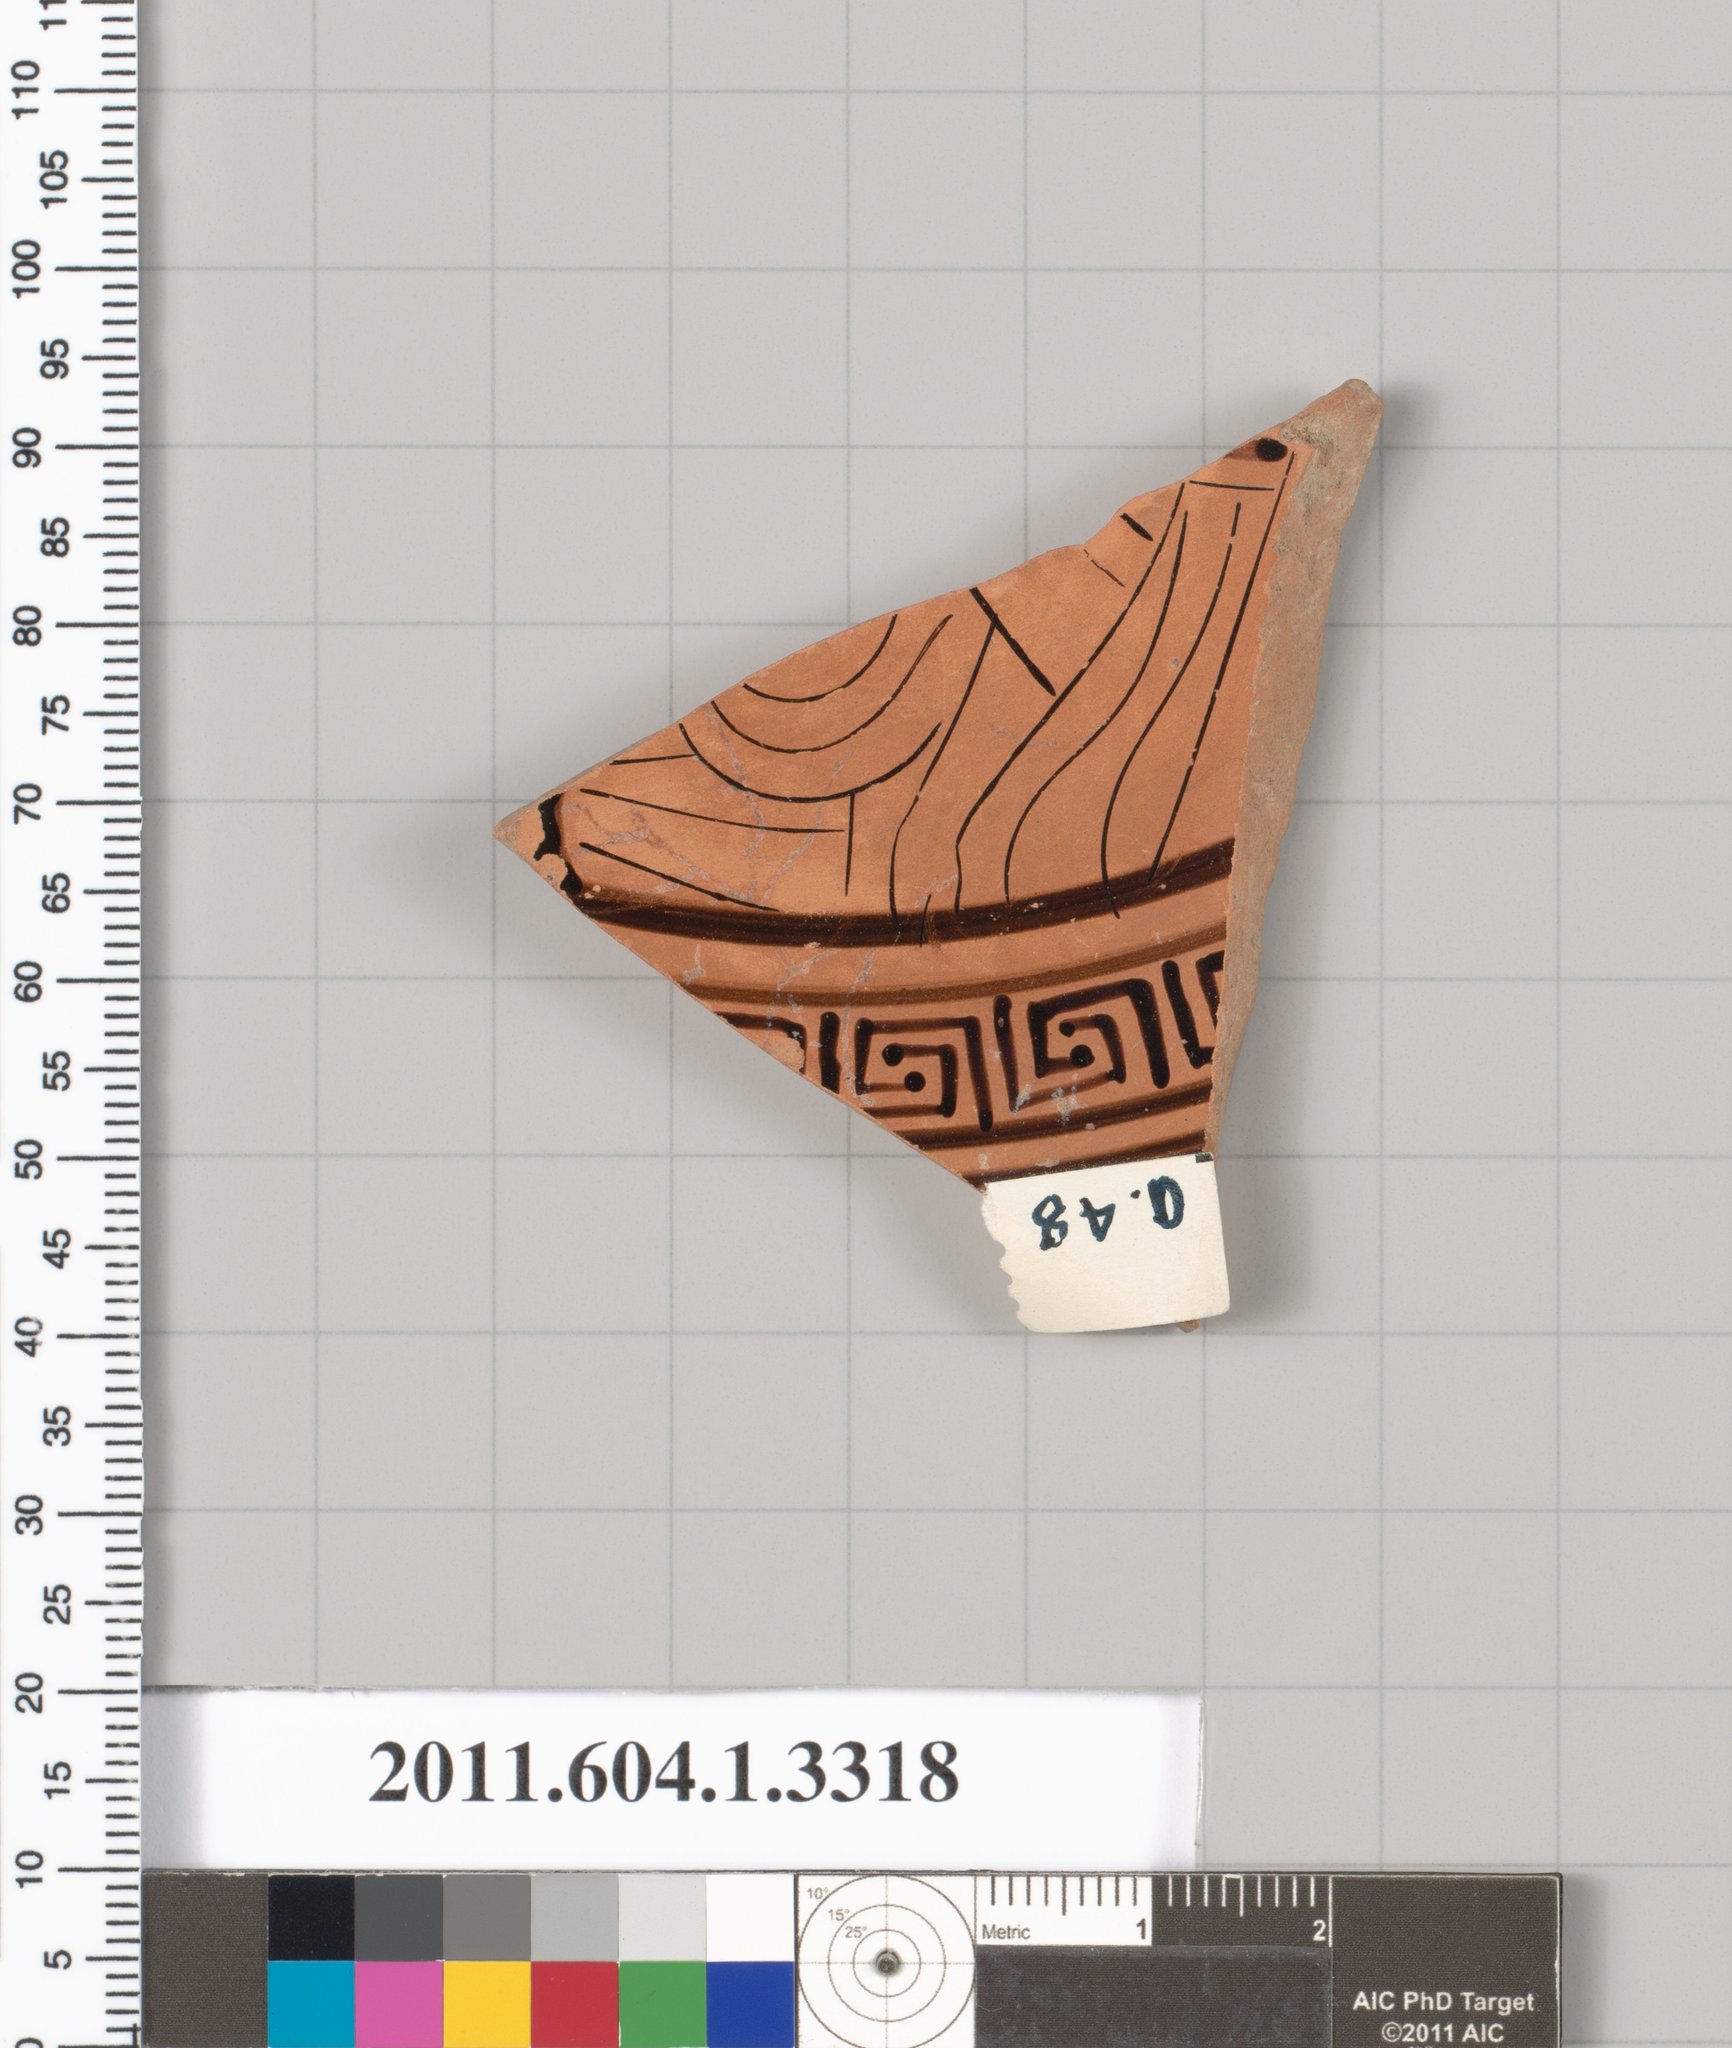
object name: kylix fragment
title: Terracotta fragment of a kylix (drinking cup)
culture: greek, attic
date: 500-480 BCE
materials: terracotta